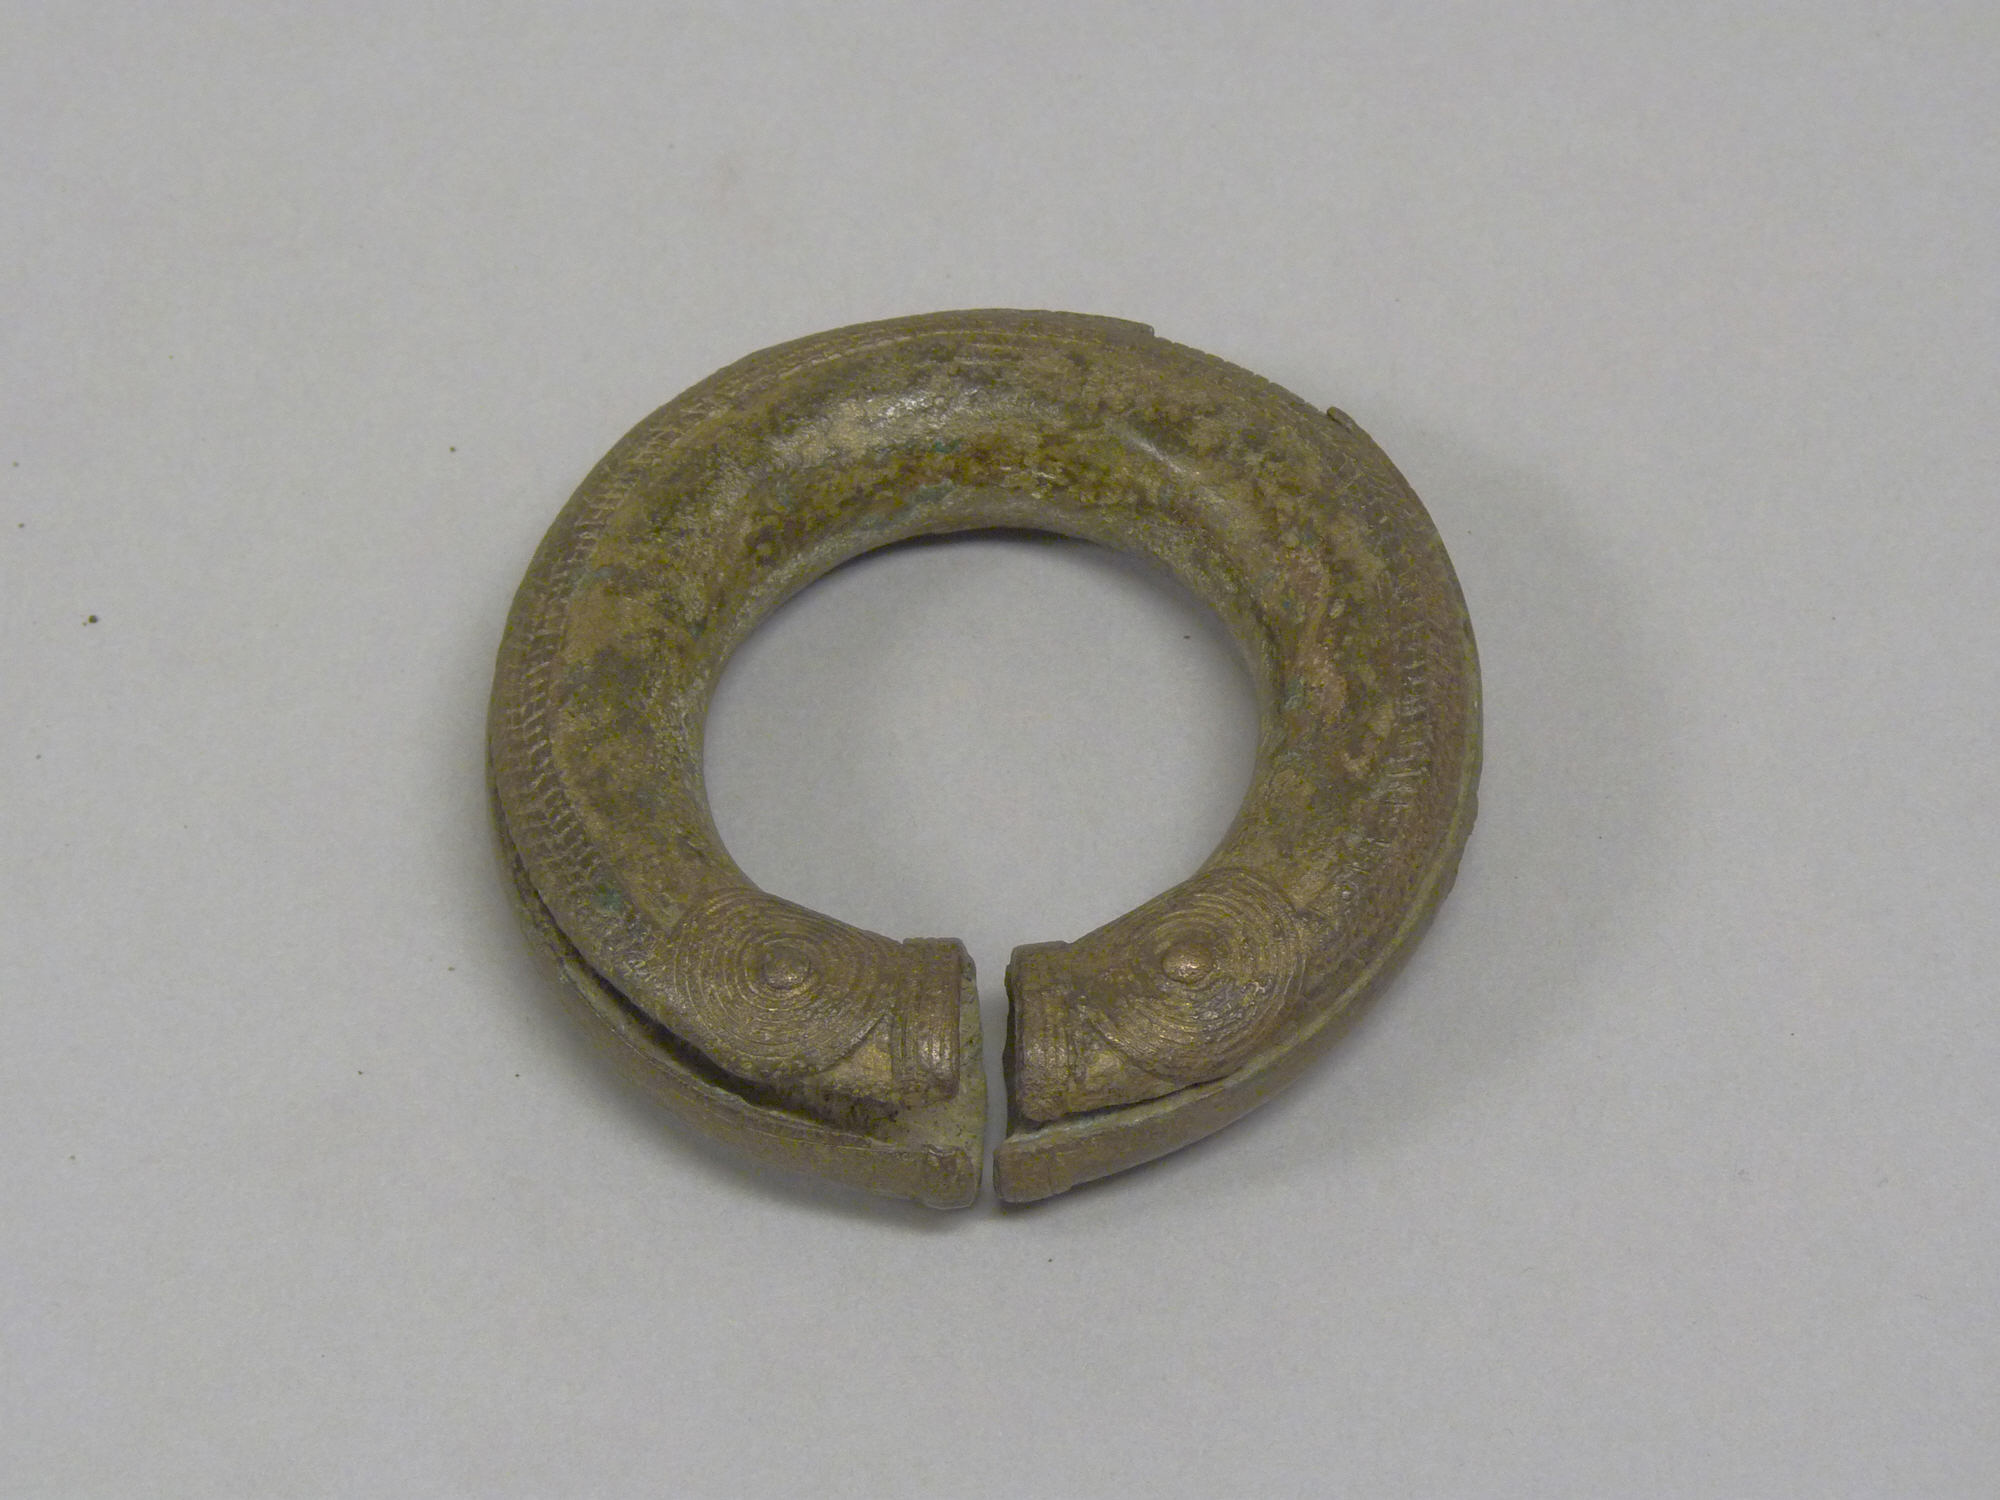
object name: bangle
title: Hollow Bangle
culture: thai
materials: bronze